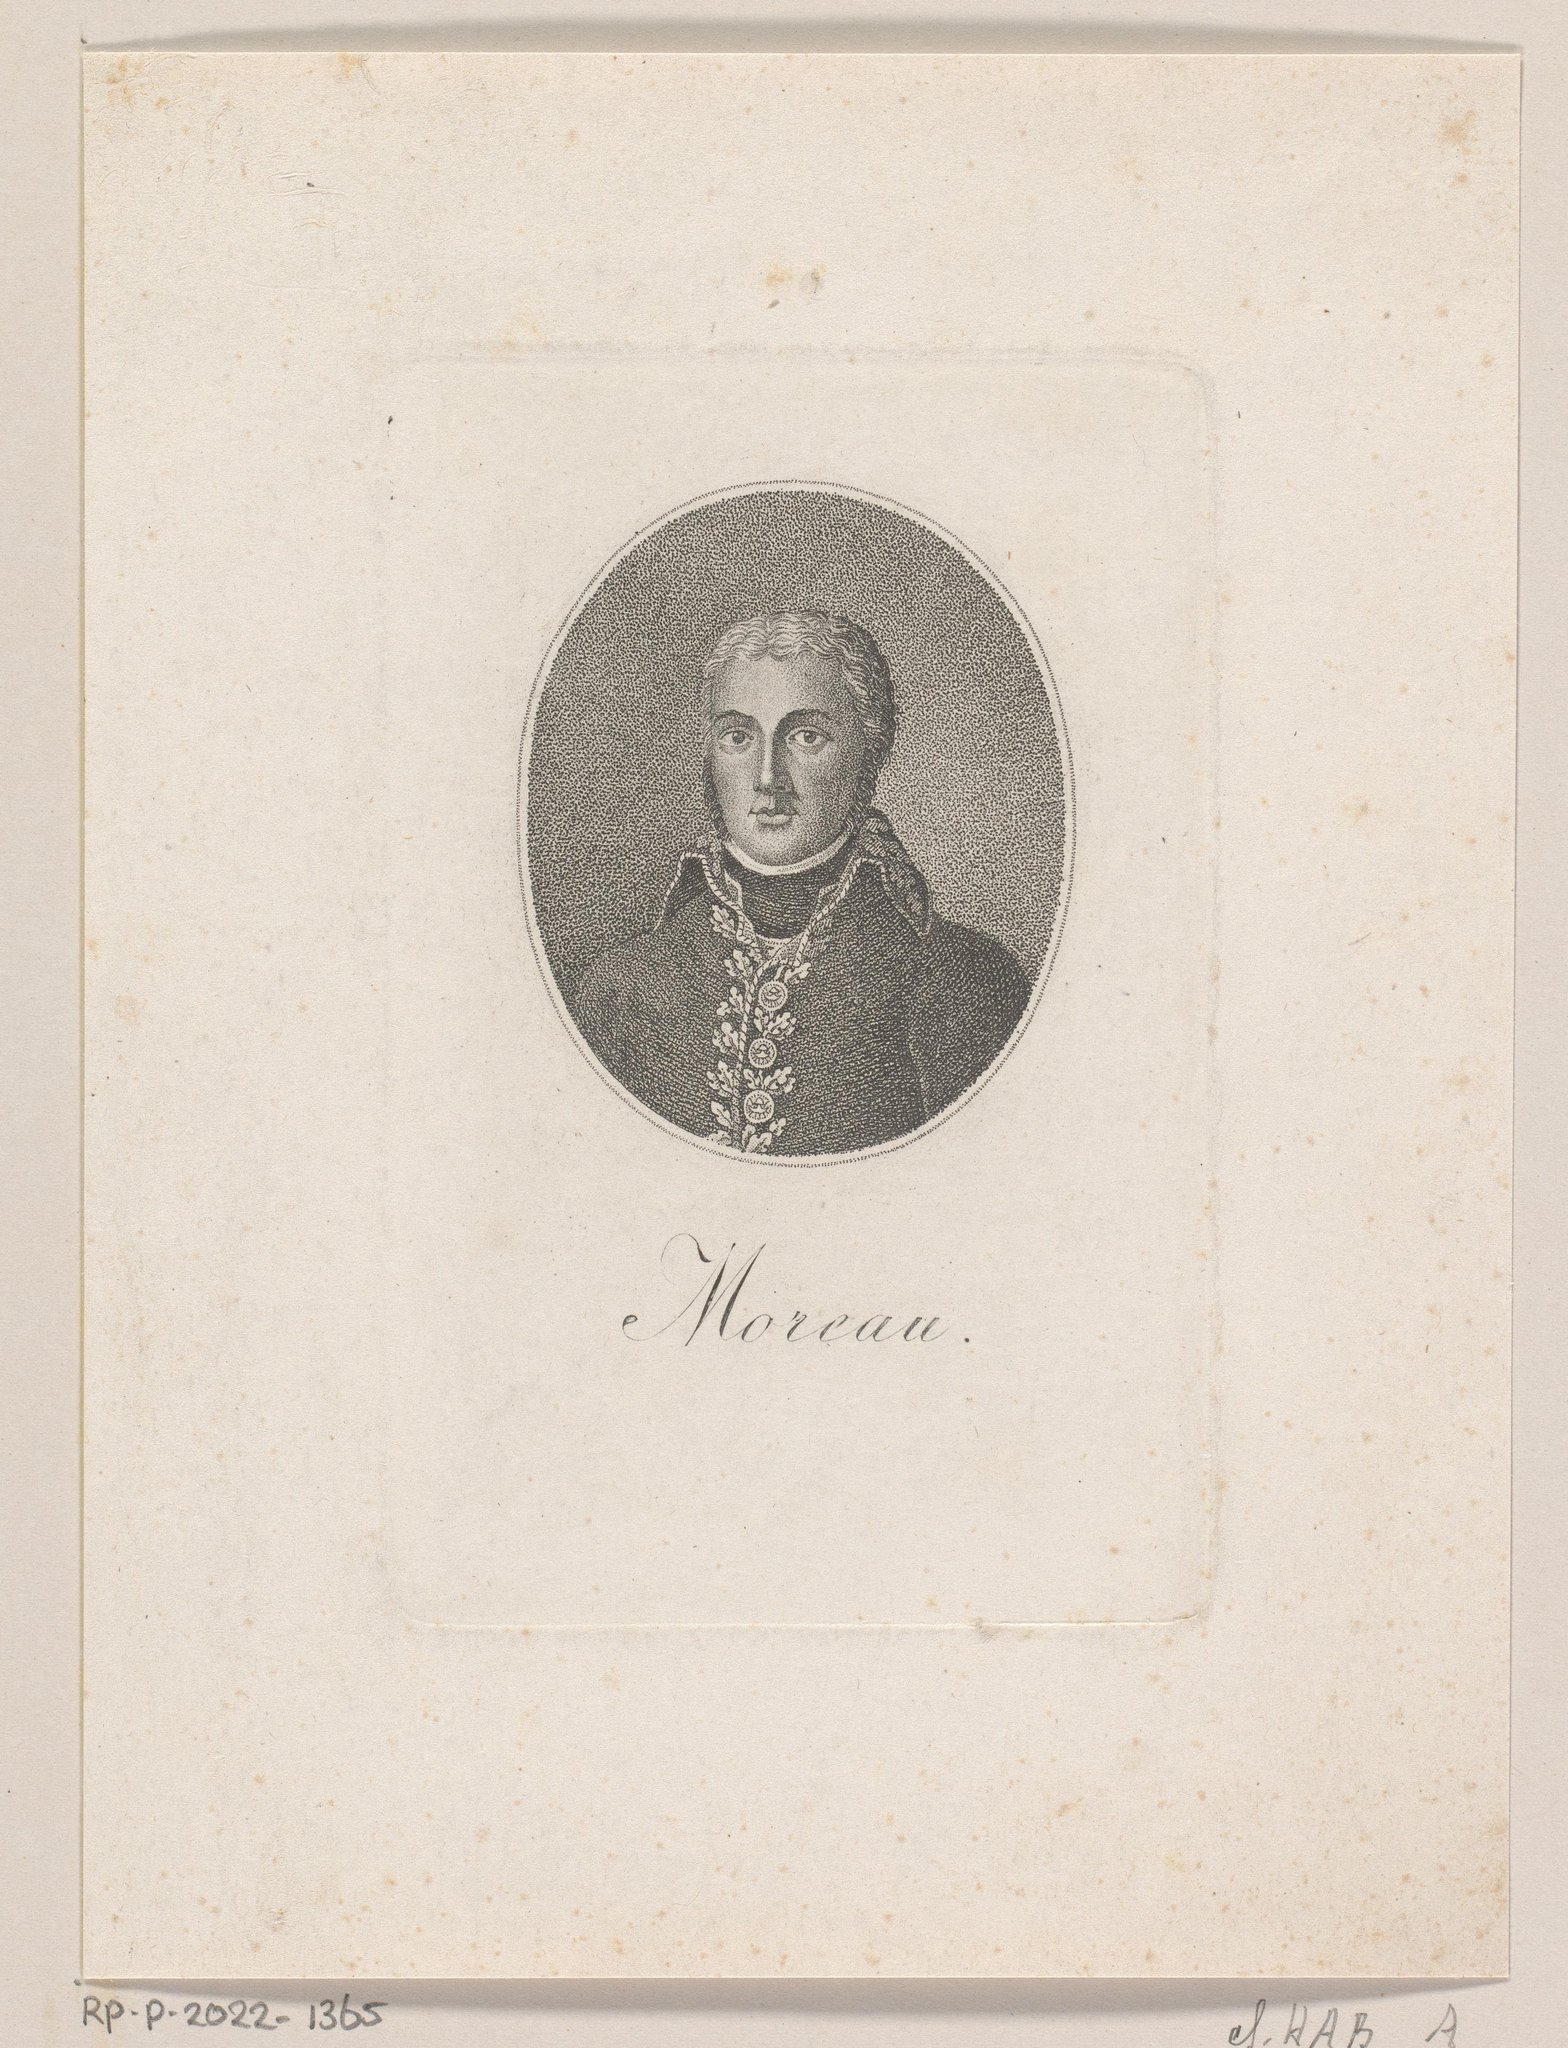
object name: print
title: Portret van Jean Victor Marie Moreau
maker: Anonymous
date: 1790-1850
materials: paper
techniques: etching, roulette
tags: commander-in-chief, general, marshal, historical persons